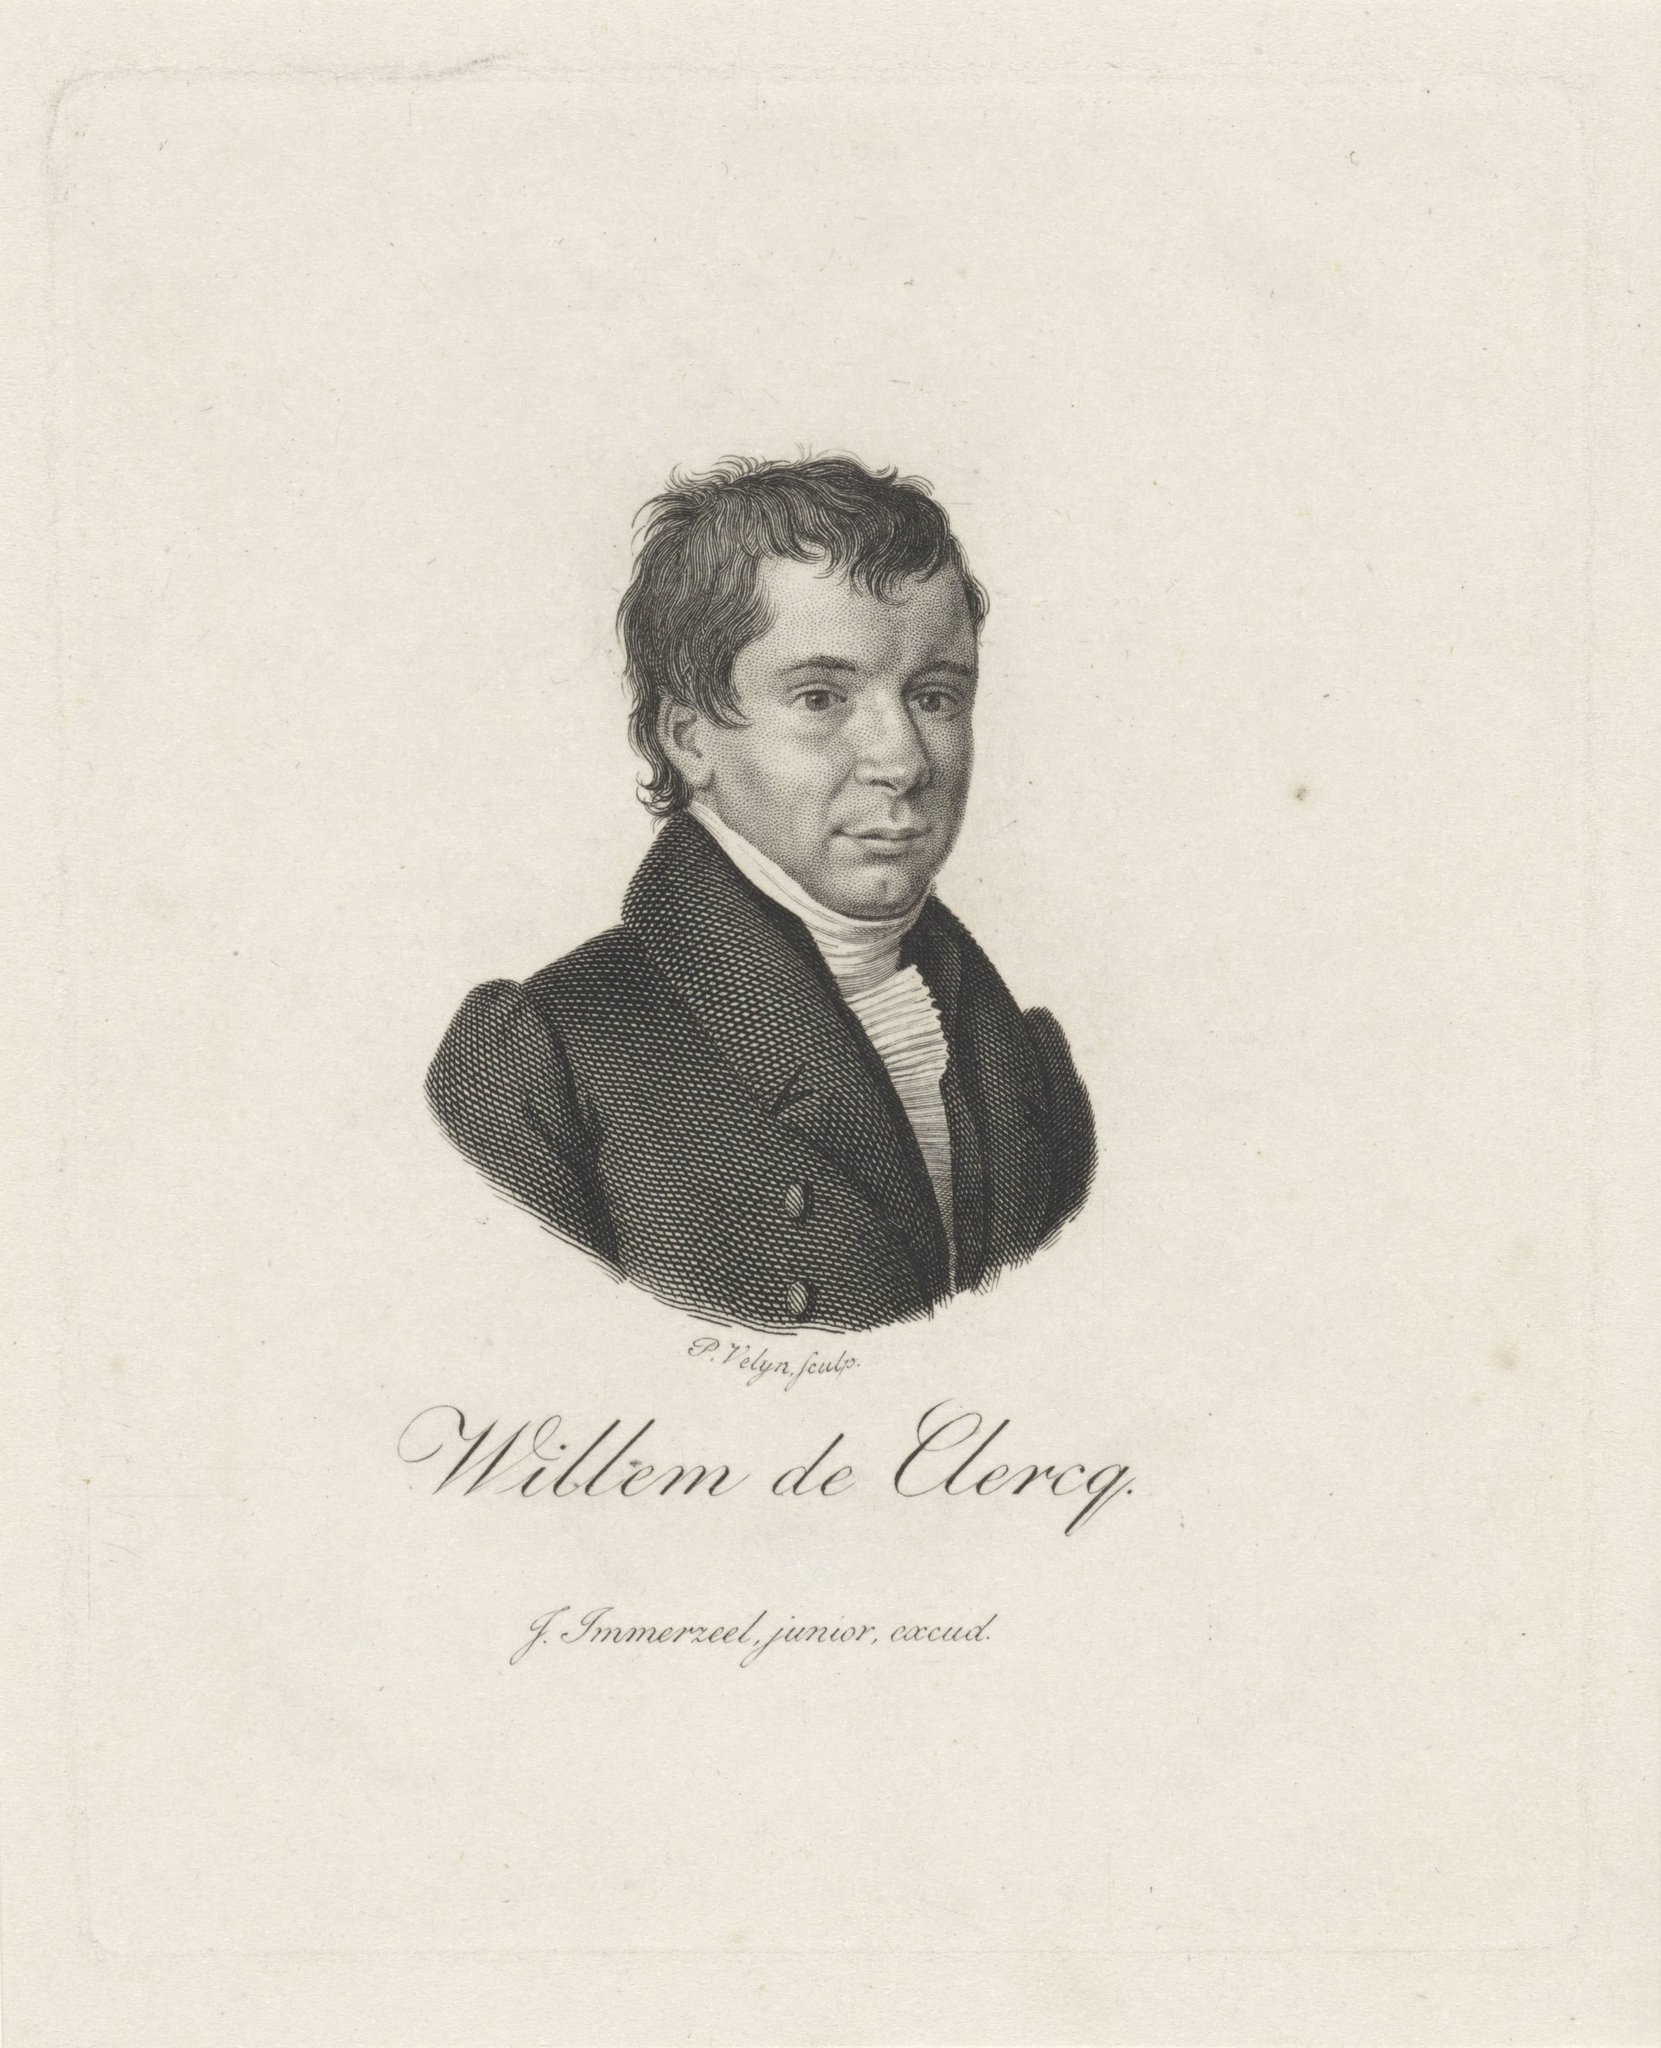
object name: print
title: Portret van Willem de Clercq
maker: philippus velijn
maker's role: print maker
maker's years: 1787-1836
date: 1797-1836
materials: paper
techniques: engraving, etching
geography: netherlands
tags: amsterdam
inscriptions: collector's mark: Lugt 2228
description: Portret van Willem de Clercq, directeur Nederlandsche Handels Maatschappij en dichter.